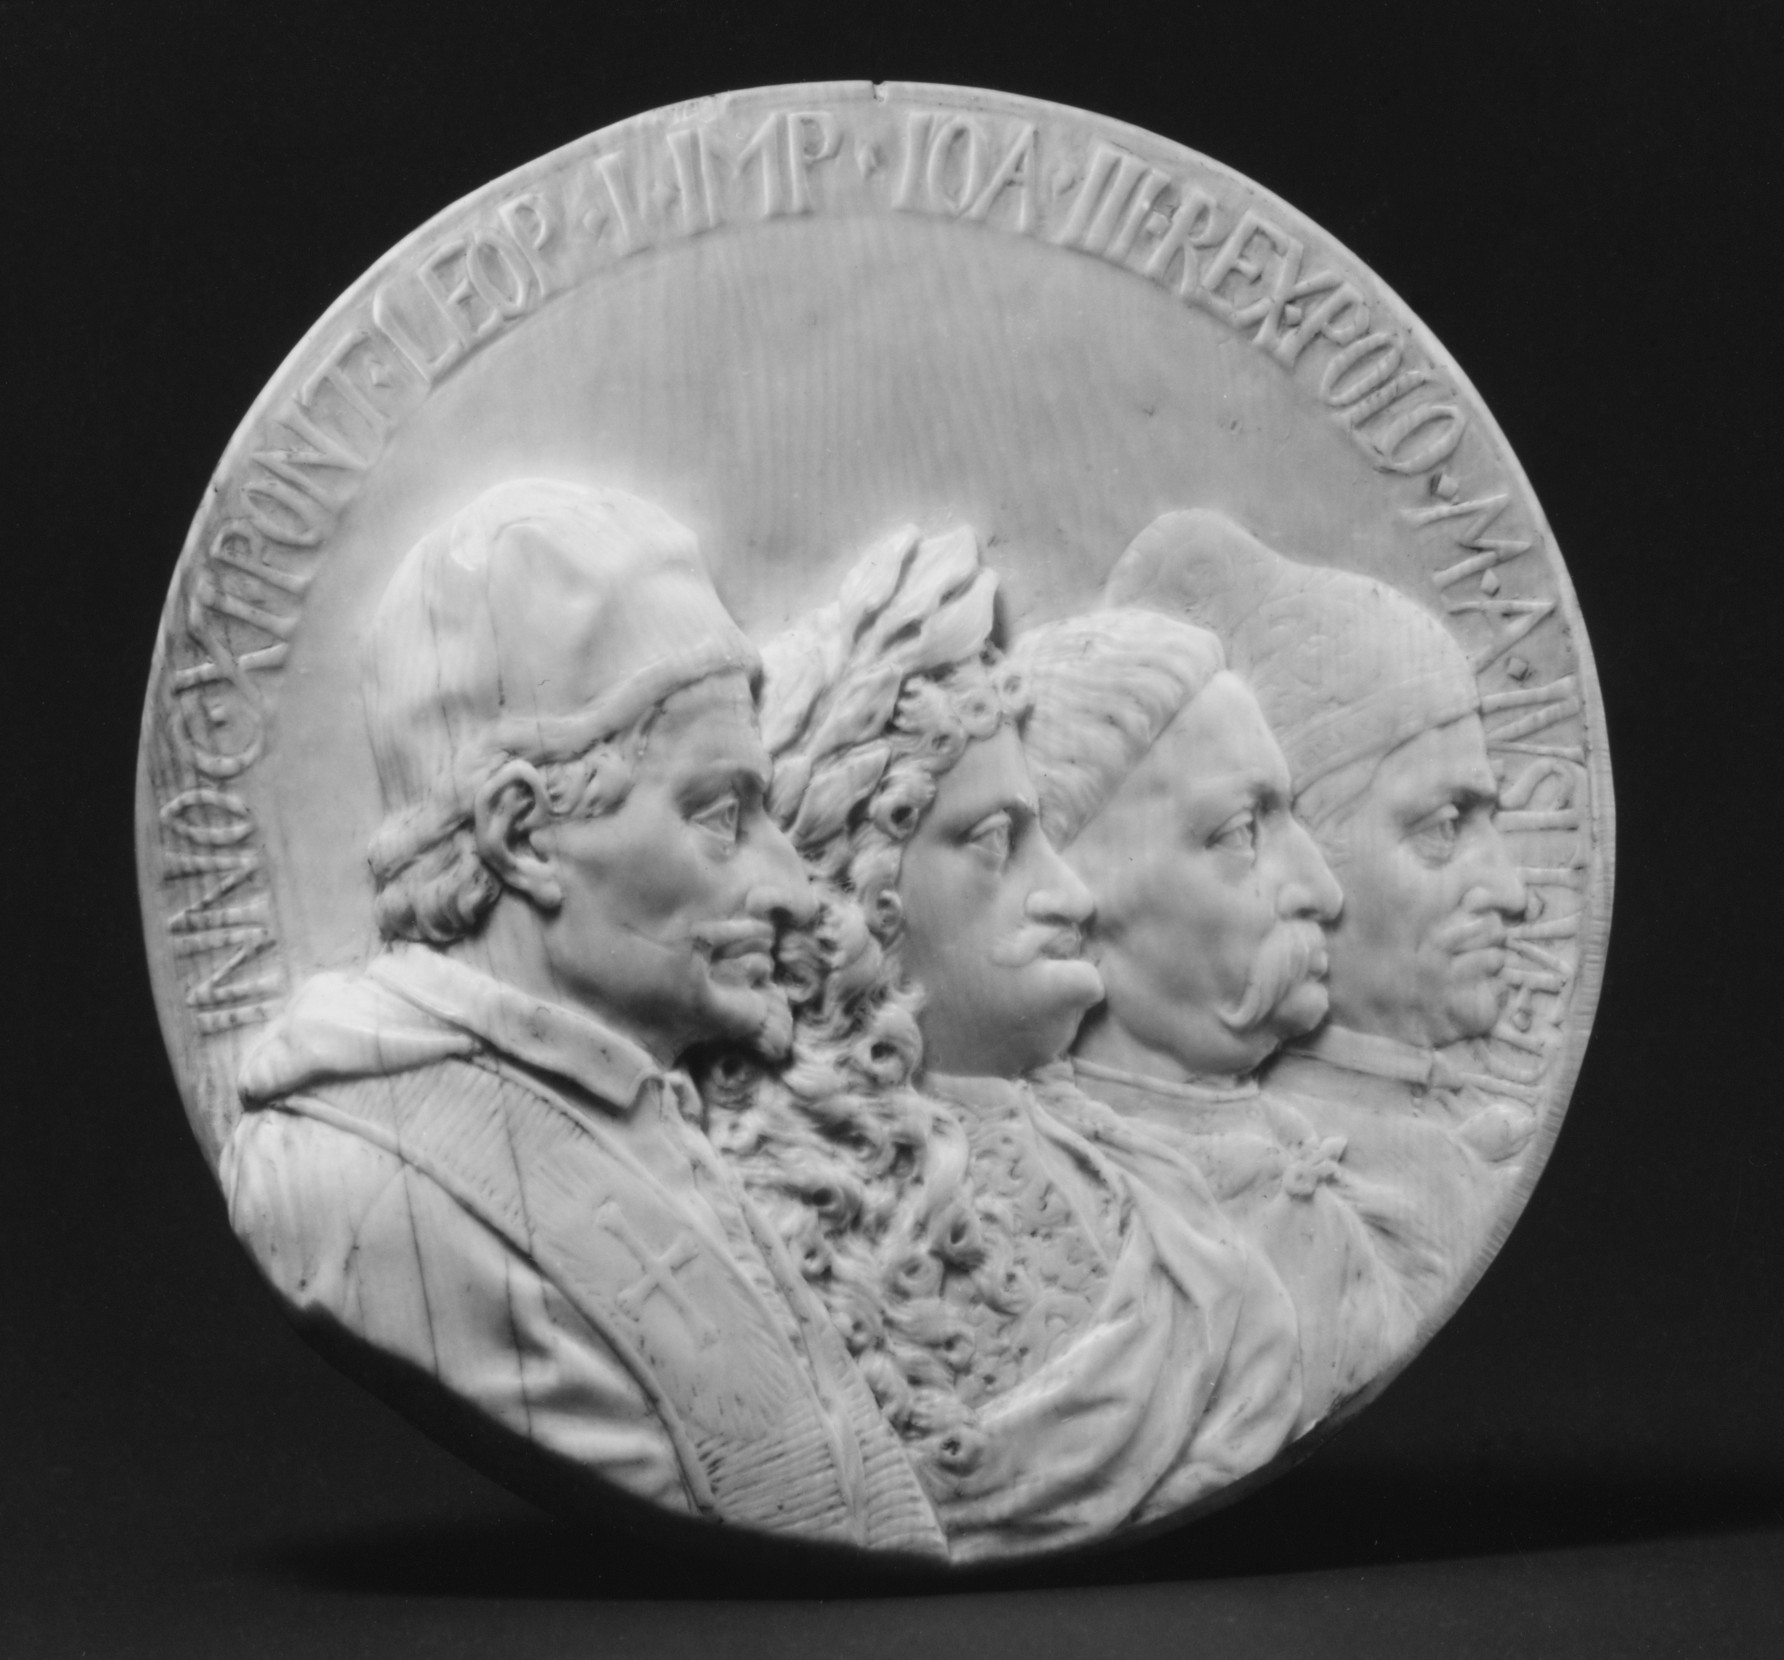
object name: medallion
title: The Relief of Vienna, September 12, 1683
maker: johan ignaz bendl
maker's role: artist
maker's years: 1630-1730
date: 1683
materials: ivory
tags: men,profiles